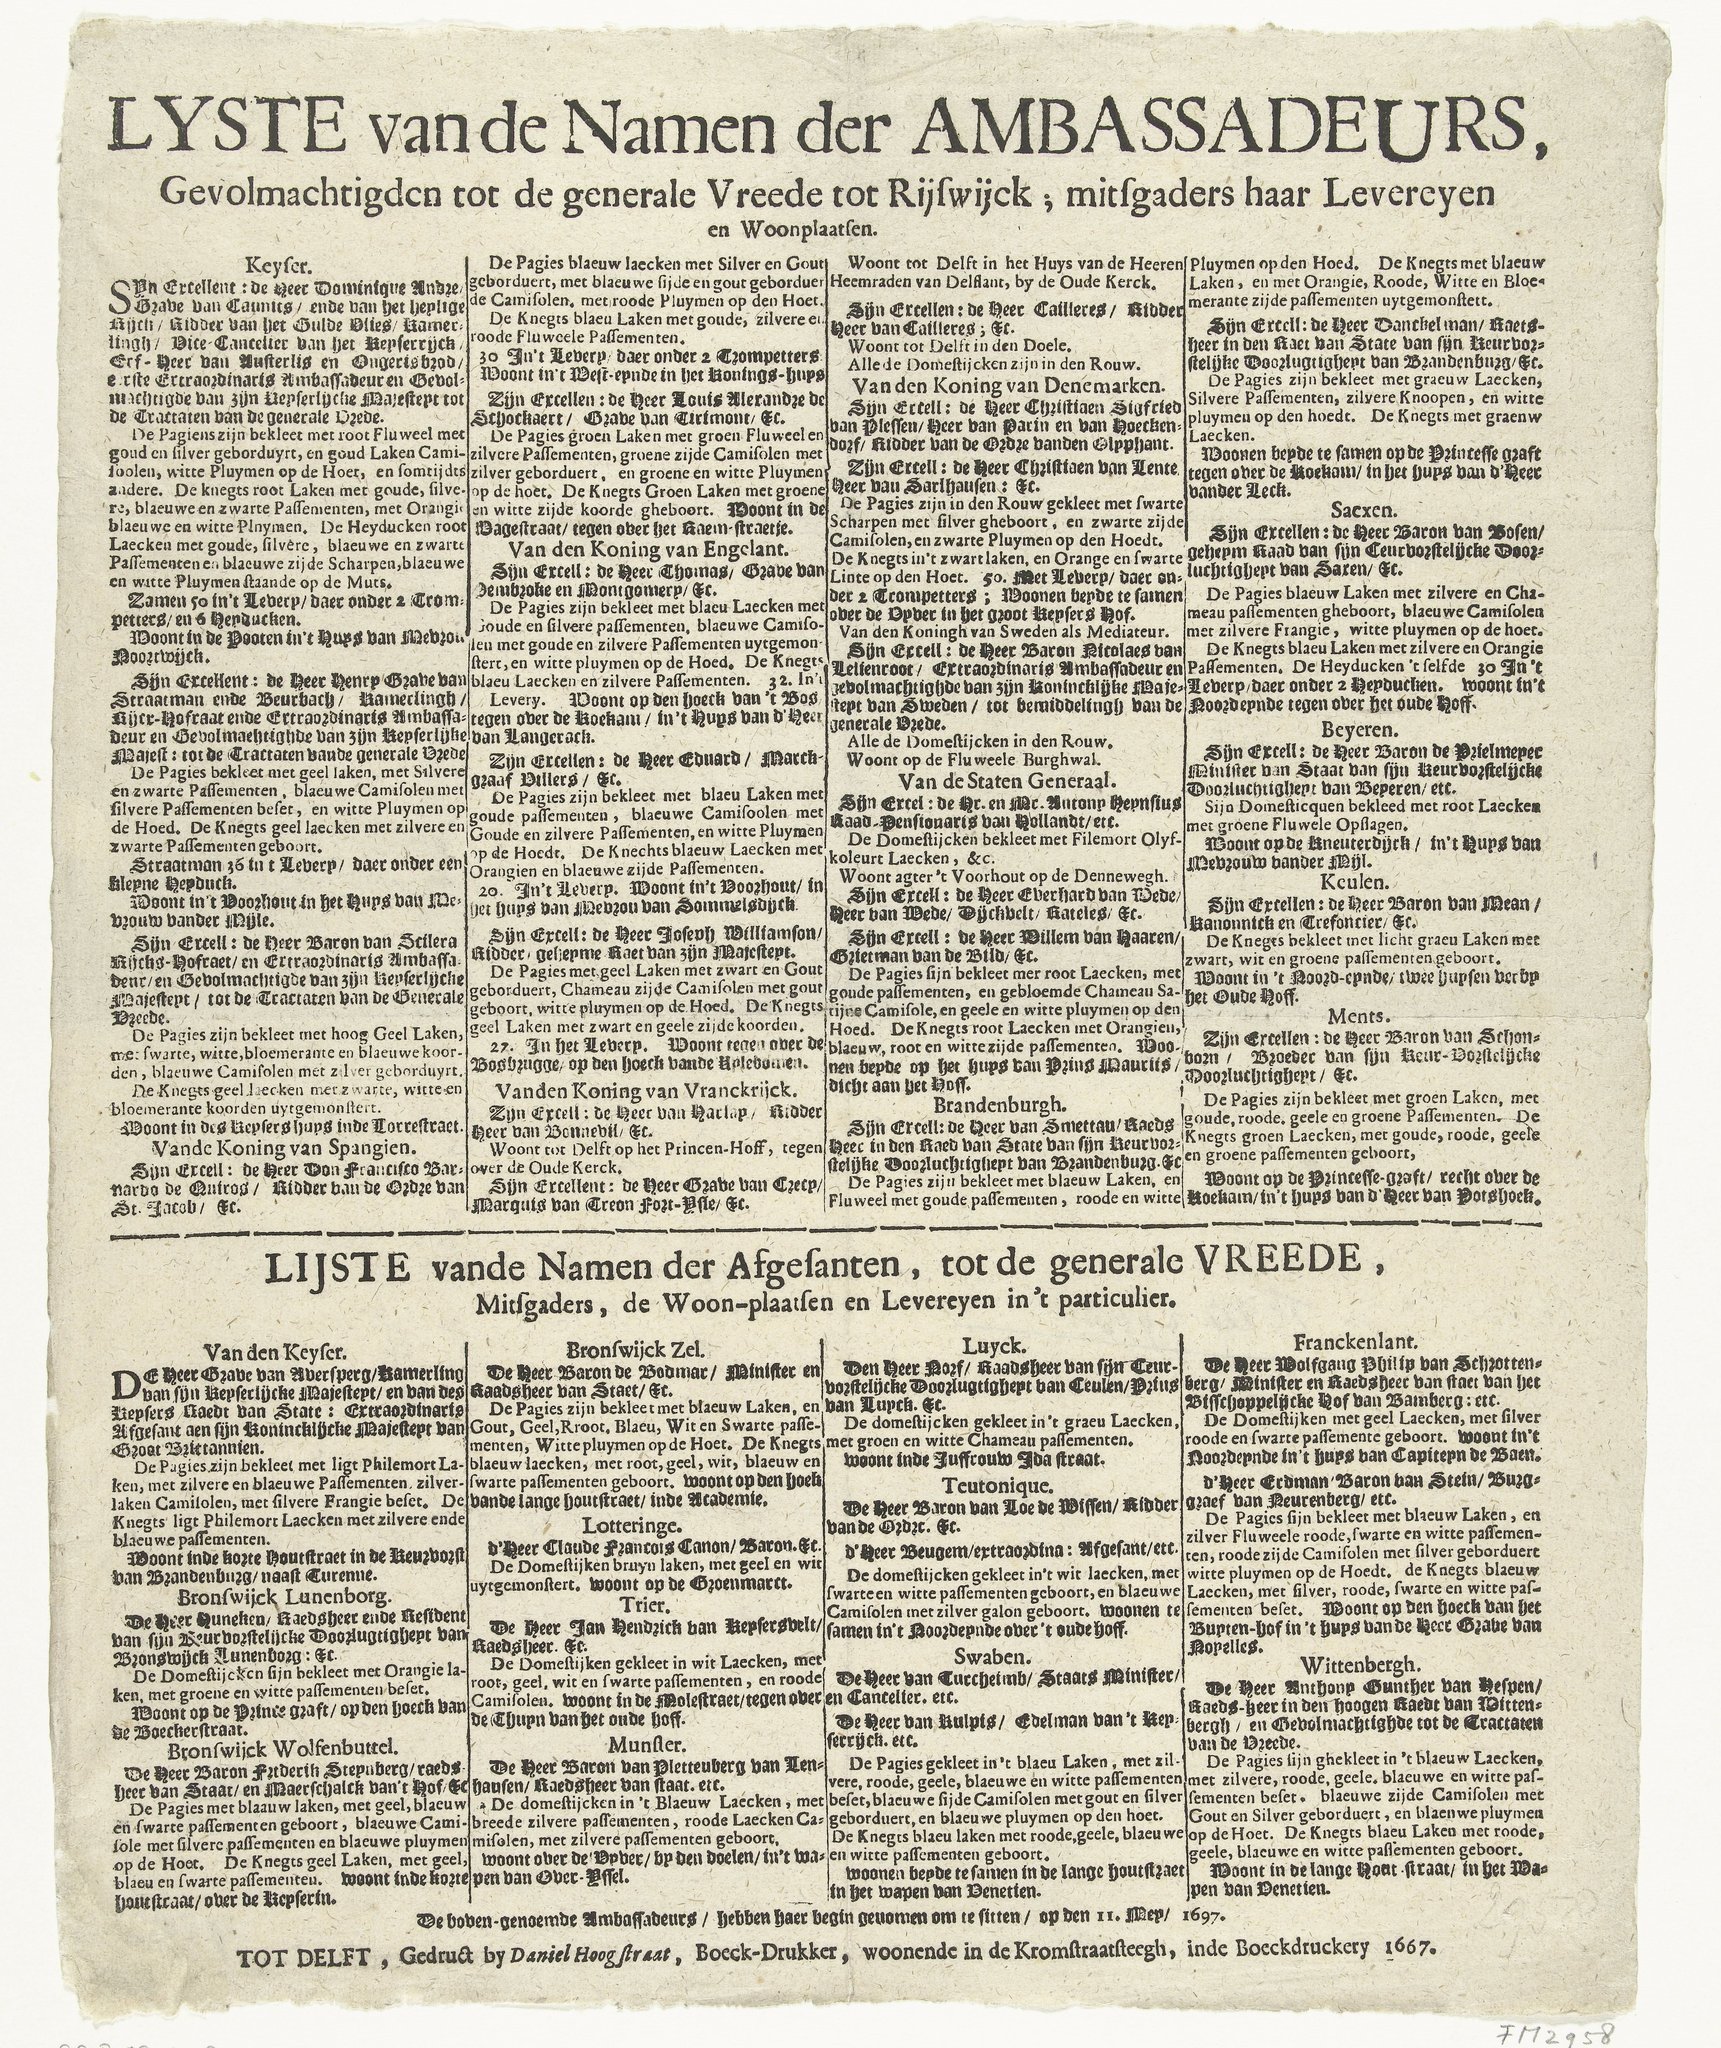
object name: text sheet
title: Lijst met de namen van de onderhandelaars bij de vrede van Rijswijk, 1697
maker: daniel hoogstraat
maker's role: printer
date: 1697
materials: paper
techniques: letterpress printing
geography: delft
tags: vrede van rijswijk (1697)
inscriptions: date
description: Blad met lijsten met de namen van de ambassadeurs en de afgezanten van de geallieerden bij de vredesonderhandelingen te Rijswijk, 1697. Tekst in 4 kolommen met per persoon de naam, beschrijving van de livrei van het personeel en de woonplaats.